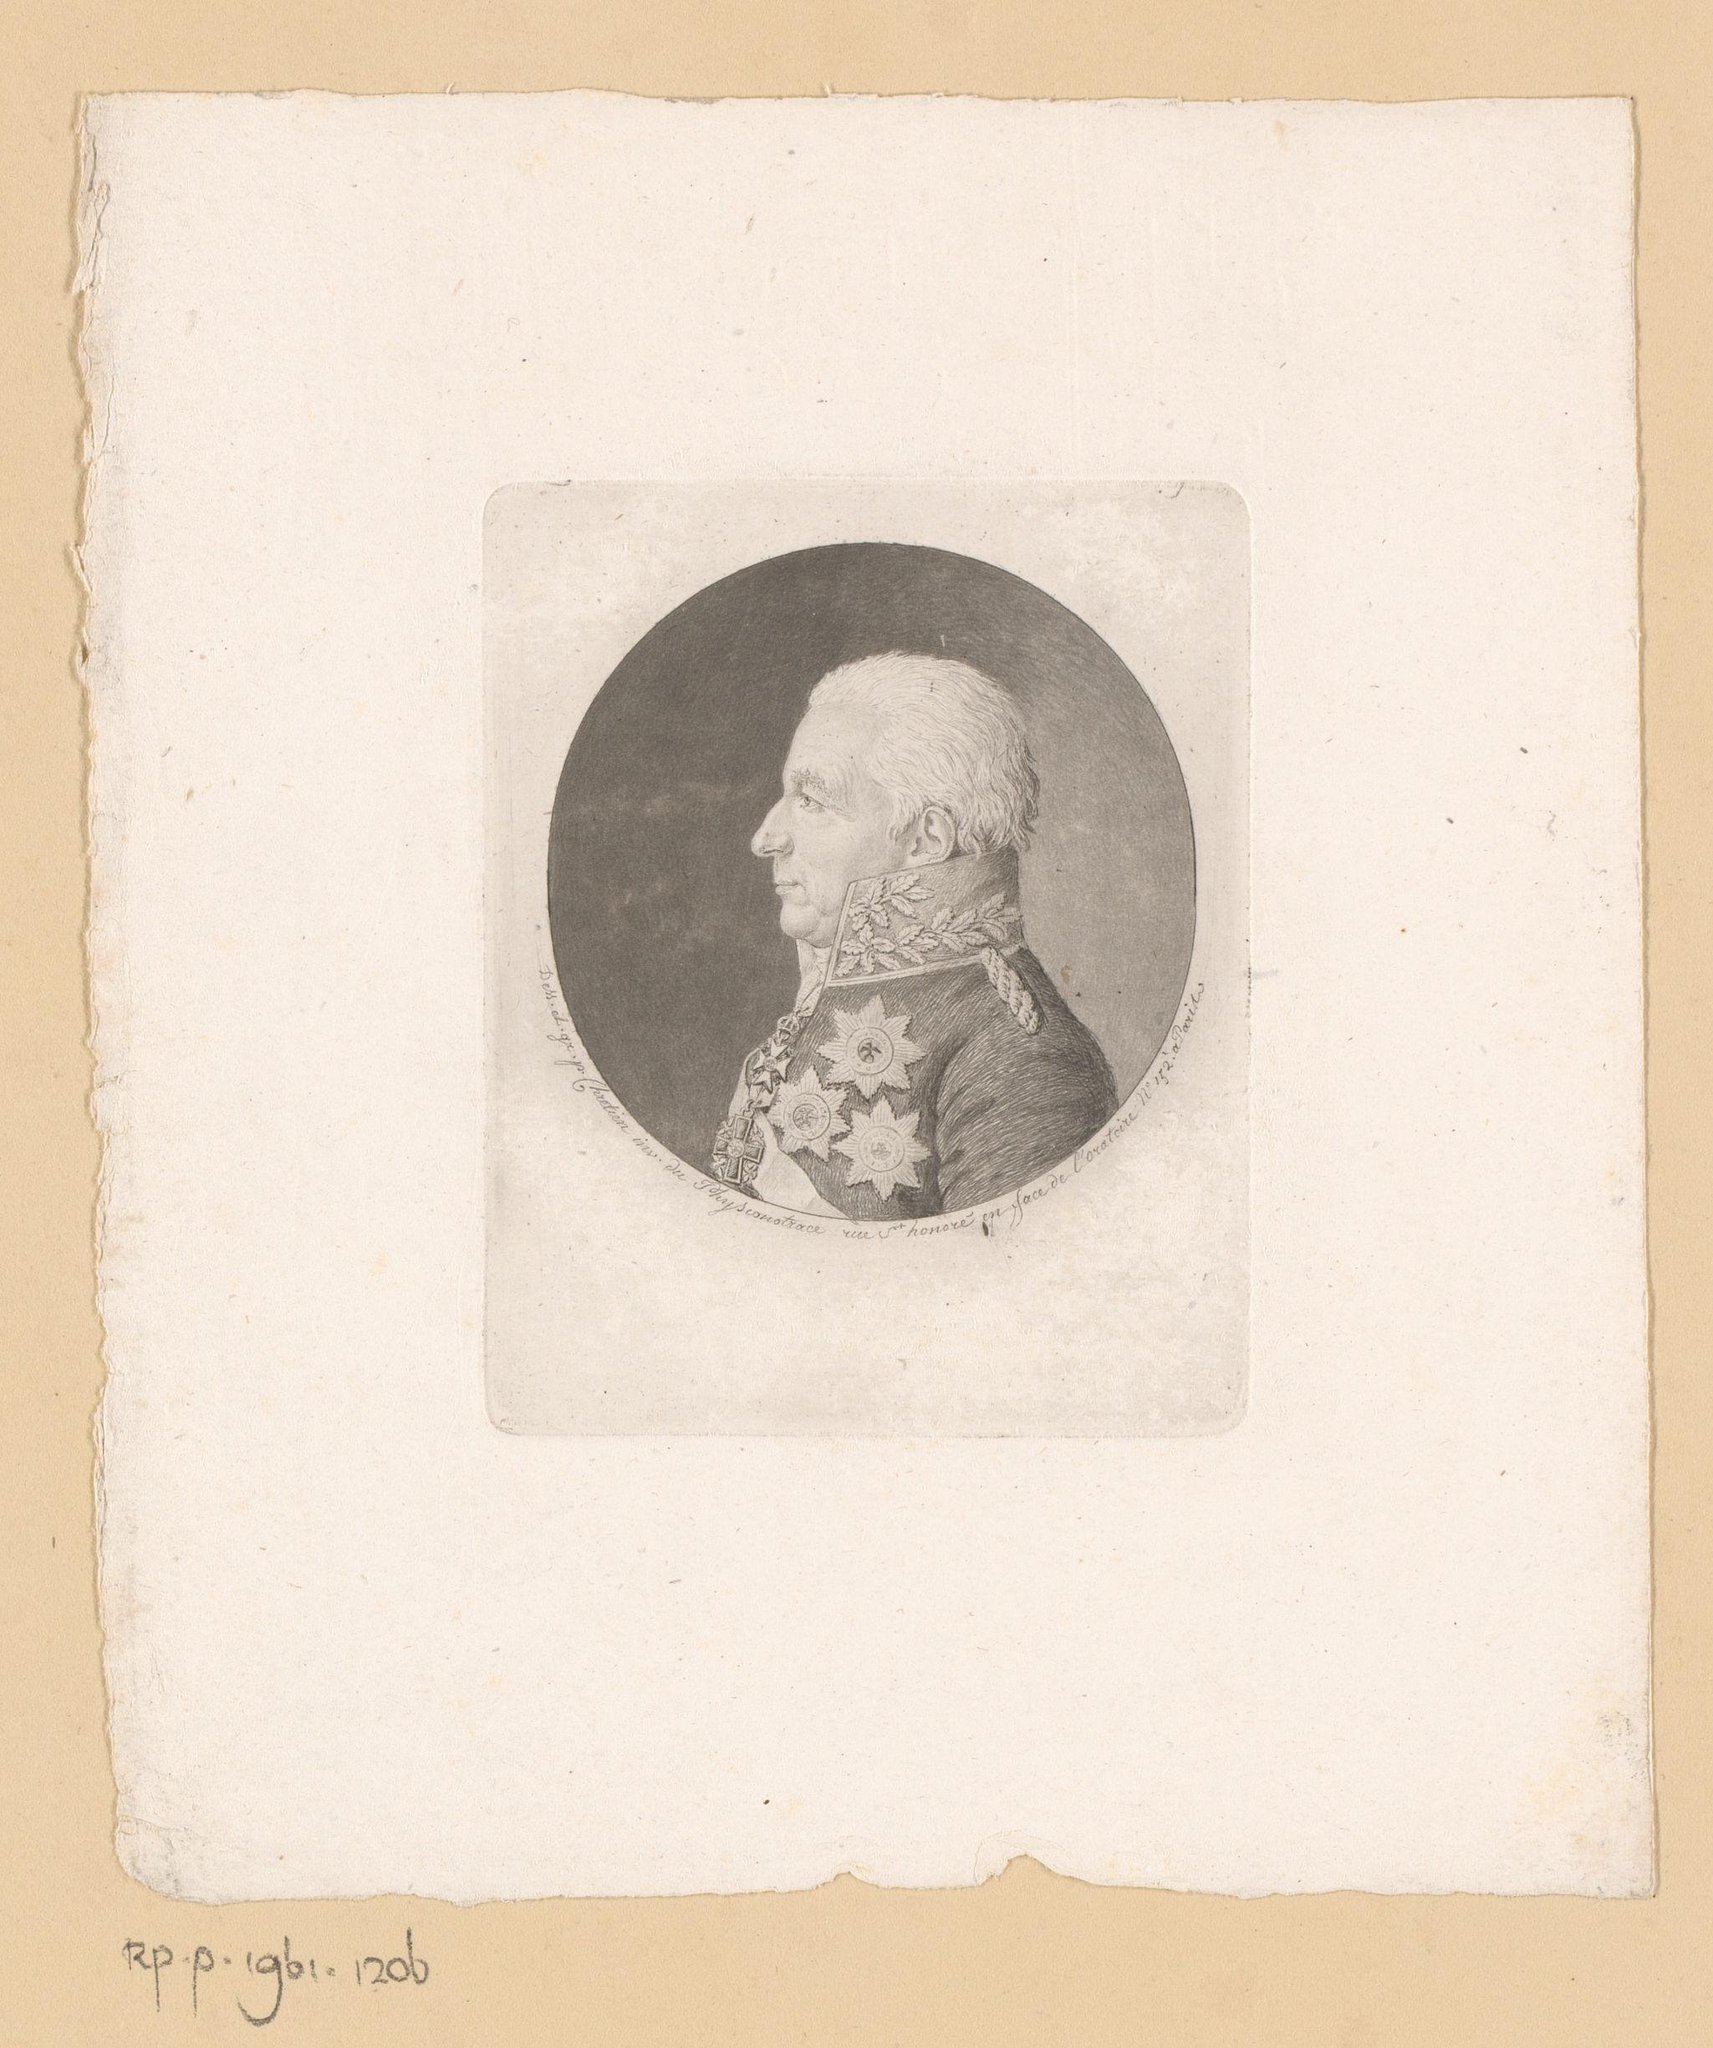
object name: print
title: Portret van Johann David Ludwig graaf Yorck von Wartenburg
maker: gilles louis chrétien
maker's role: print maker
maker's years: 1754-1811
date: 1785-1811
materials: paper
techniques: aquatint, etching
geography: paris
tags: silhouette-apparatus, 'physionotrace', historical persons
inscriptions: collector's mark: Lugt 2228